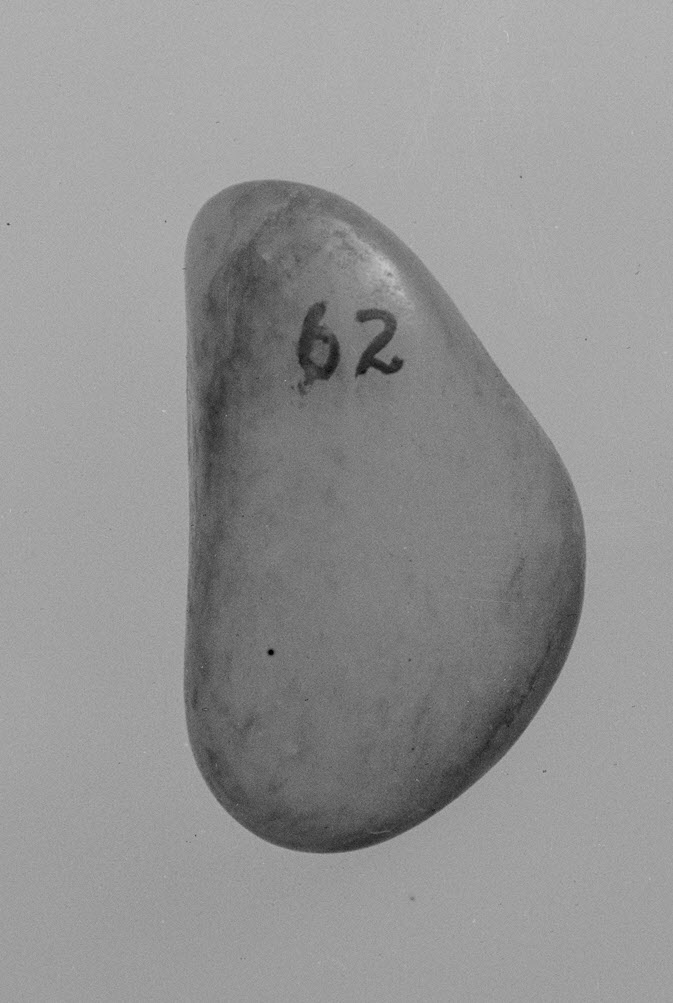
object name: pebble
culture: chinese or turkestani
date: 1902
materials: jade